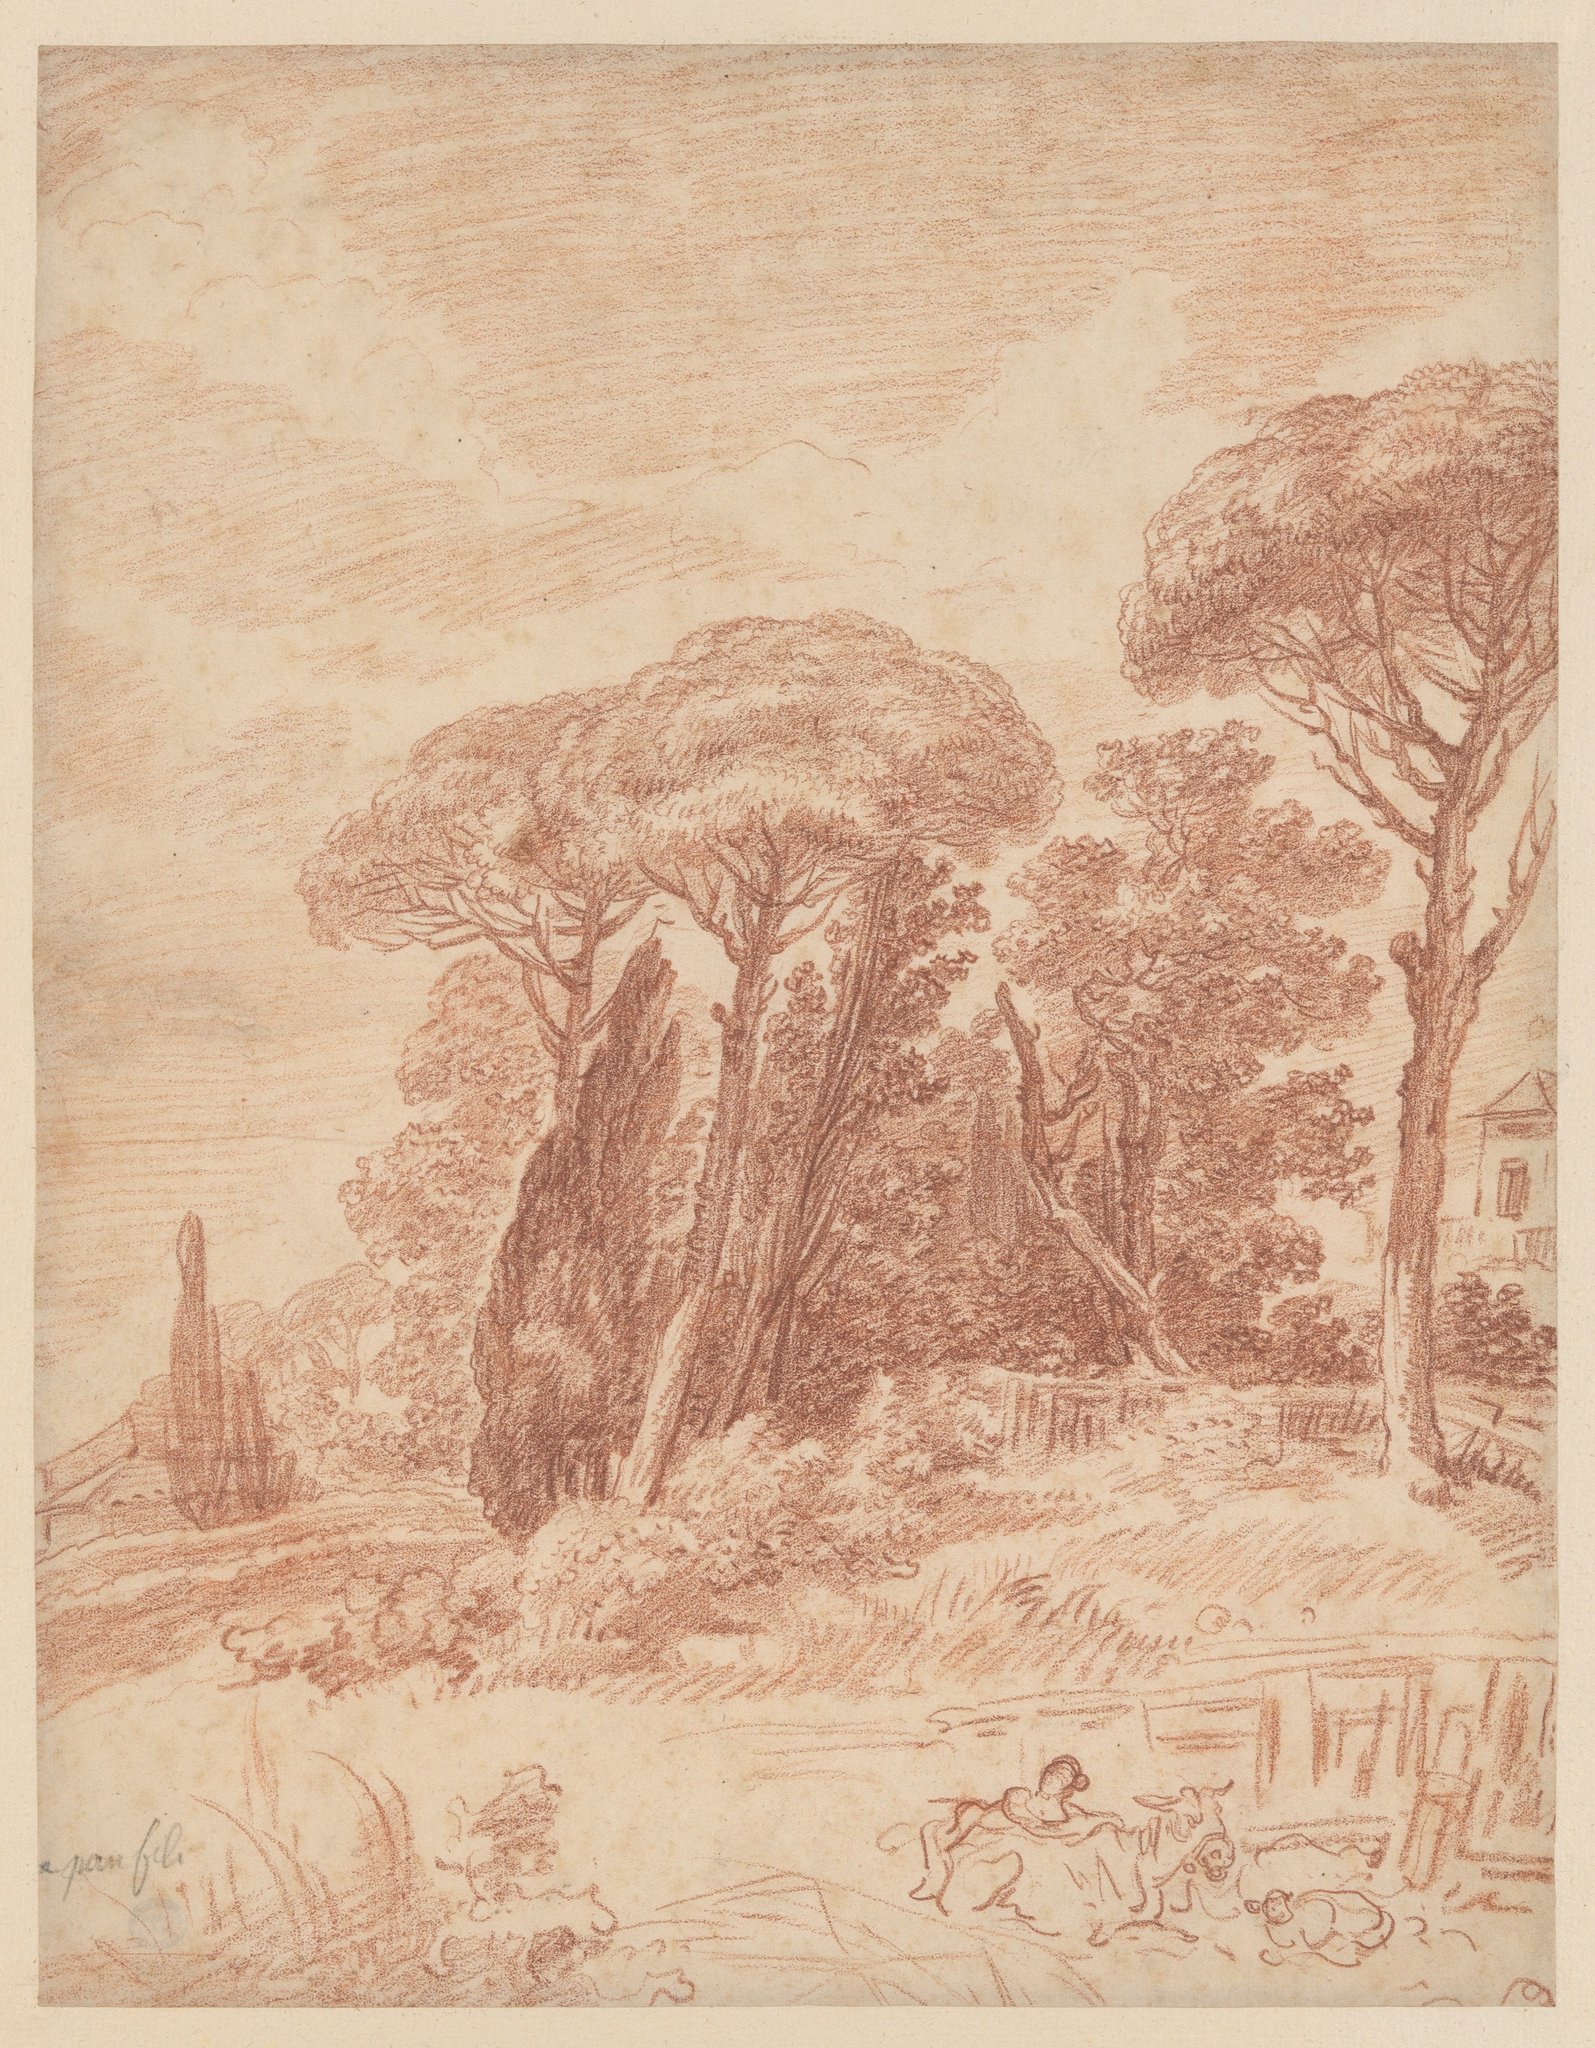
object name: drawing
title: Gardens of the Villa Pamphili, Rome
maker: hubert robert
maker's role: former attribution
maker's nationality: french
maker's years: 1733-1808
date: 1701-1800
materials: chalk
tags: gardens,cows,trees